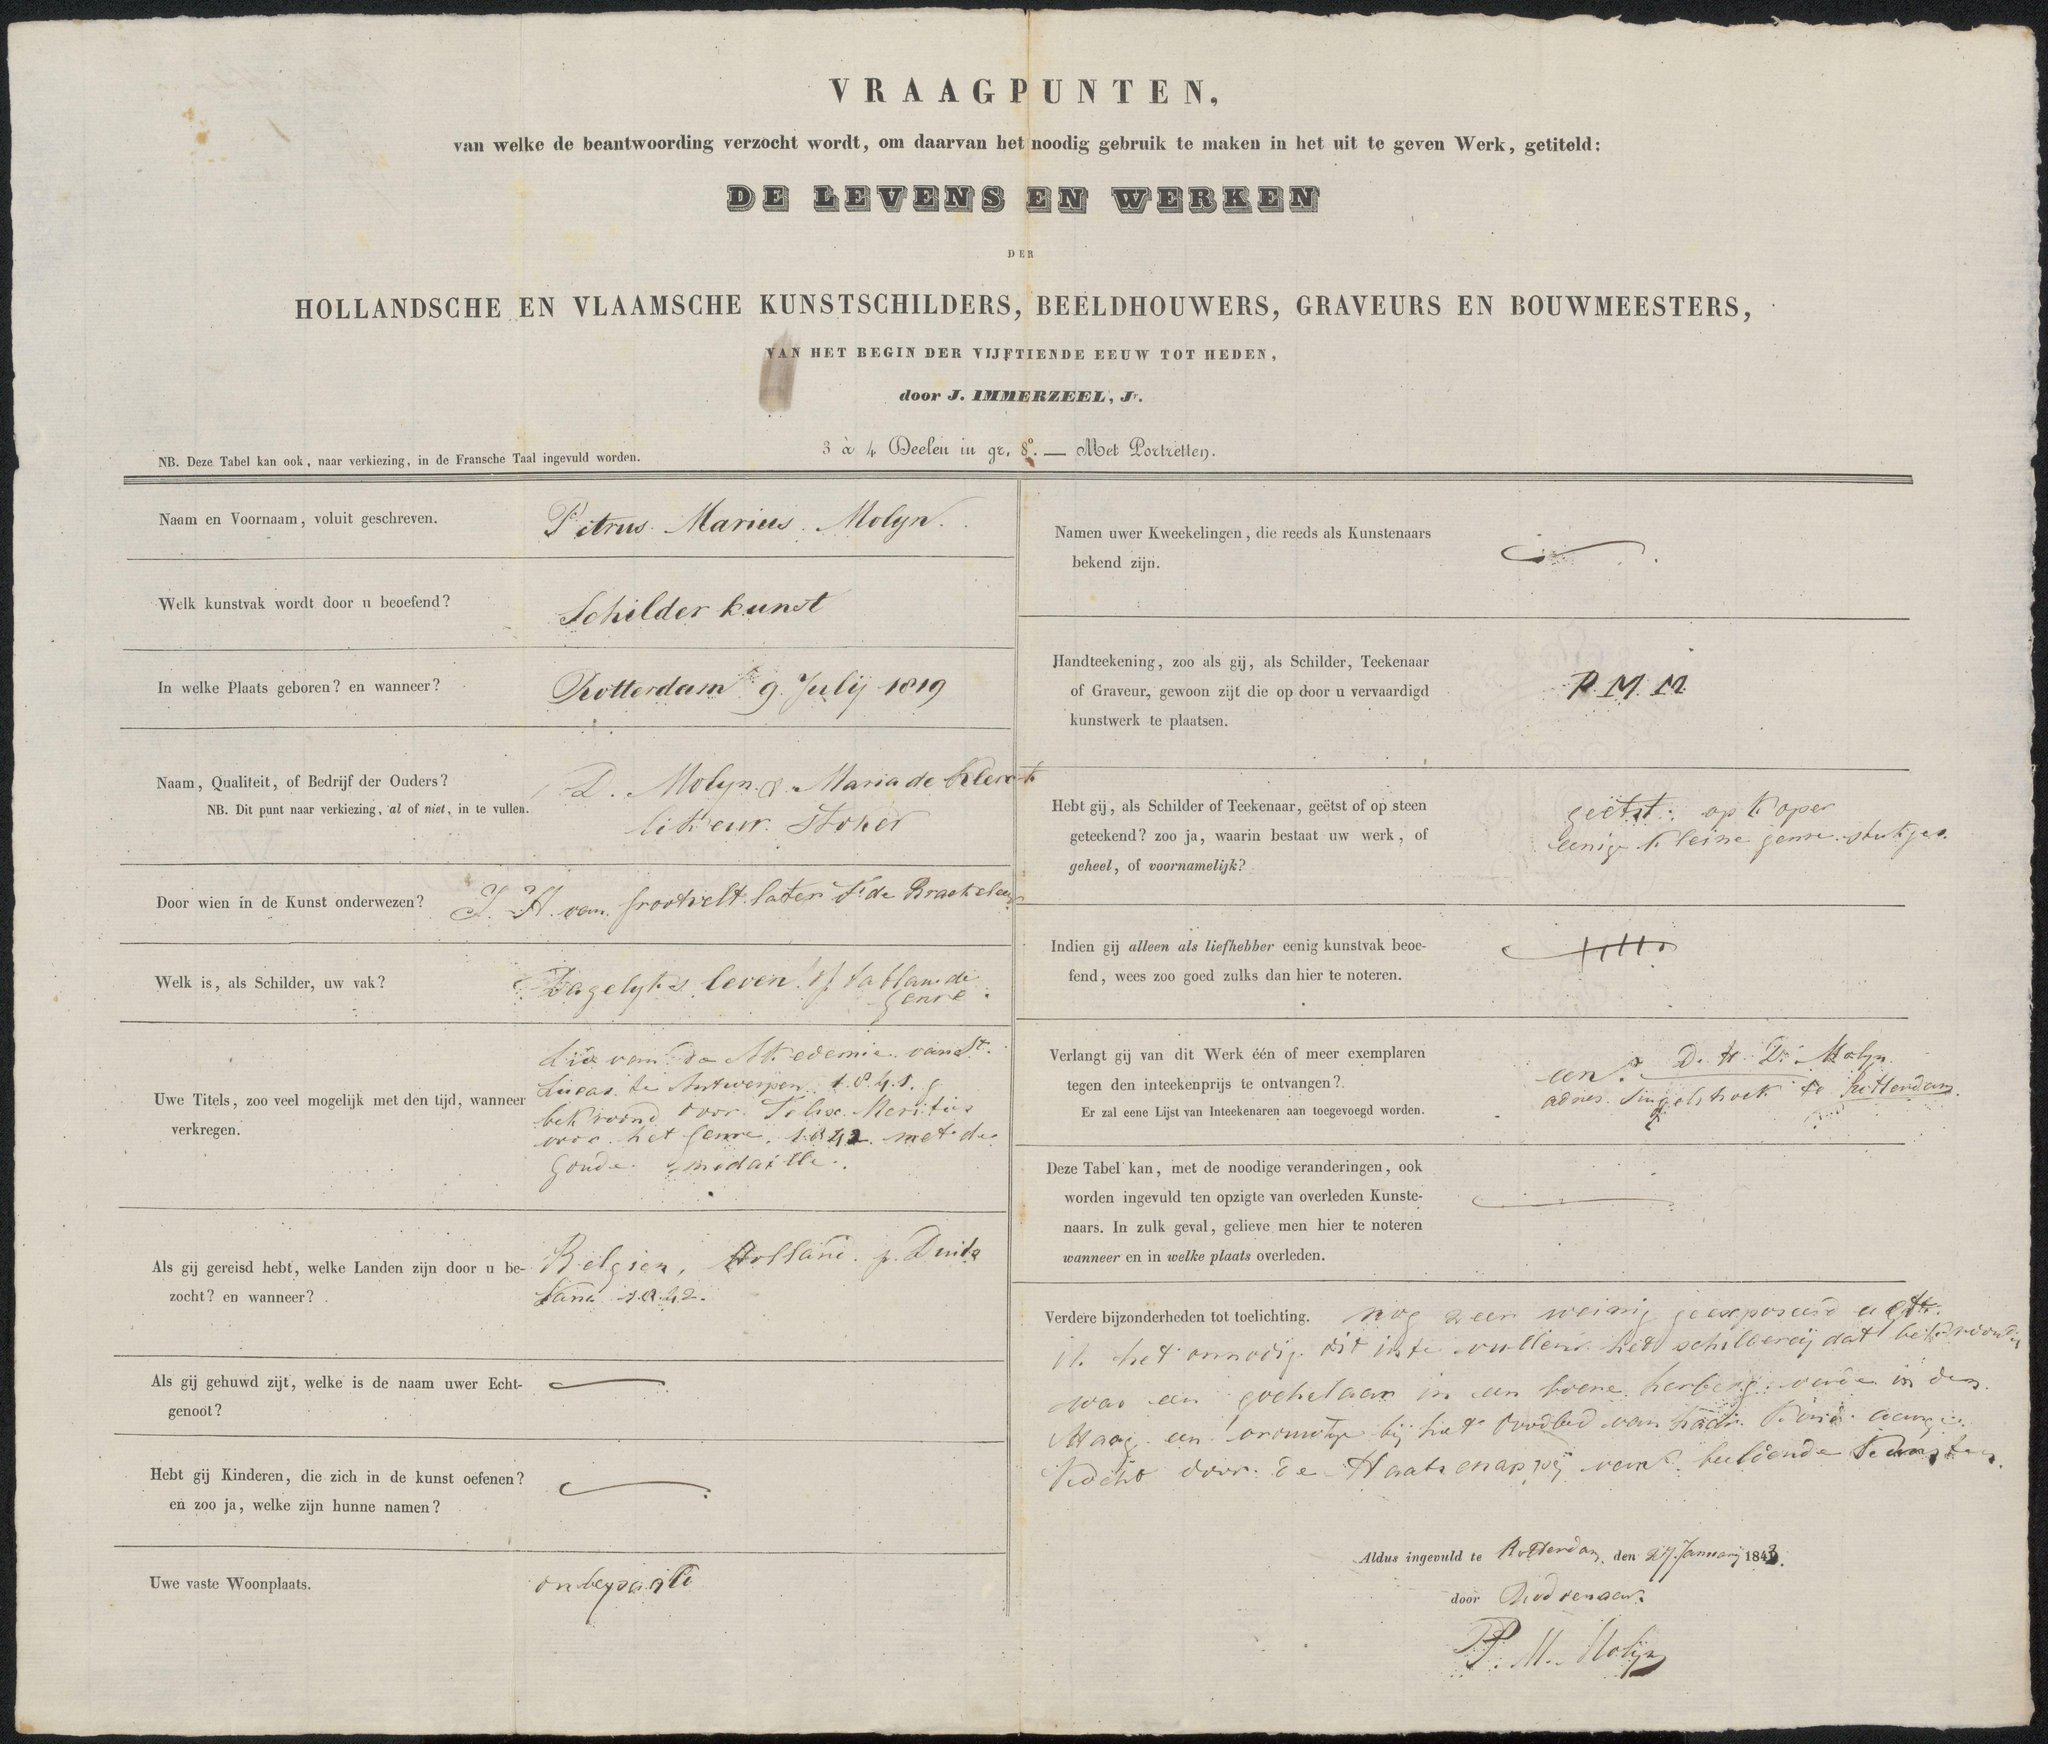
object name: manuscript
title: Enquêteformulier ingevuld door Petrus Marius Molijn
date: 1843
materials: ink, paper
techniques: pen, printing, writing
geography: rotterdam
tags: rotterdam, antwerp, print maker, draughtsman, petrus marius molijn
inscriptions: inscription: ‘Vraagpunten,/ van welke de beantwoording verzocht wordt, om daarvan het noodig gebruik te maken in het uit te geven Werk, getiteld: De levens en werken/ der Hollandsche en Vlaamsche kunstschilders, beeldhouwers,/ graveurs en bouwmeesters, van het begin der vijftiende eeuw tot heden/ door J. Immerzeel, Jr.’, watermark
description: Opgenomen in: Immerzeel, J. Jr., De levens en werken der Hollandsche en Vlaamsche kunstschilders, beeldhouwers, graveurs en bouwmeesters, van het begin der vijftiende eeuw tot heden, Amsterdam: J.C. van Kesteren, 1842-1843.